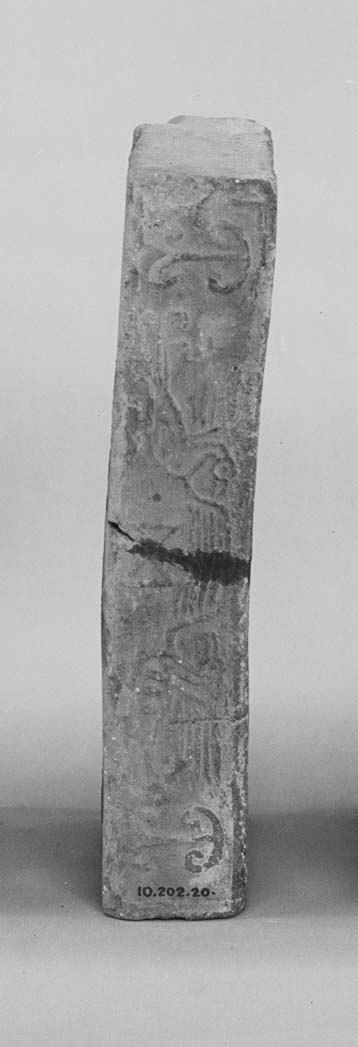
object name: tile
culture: chinese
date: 221 BCE-220 CE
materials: earthenware